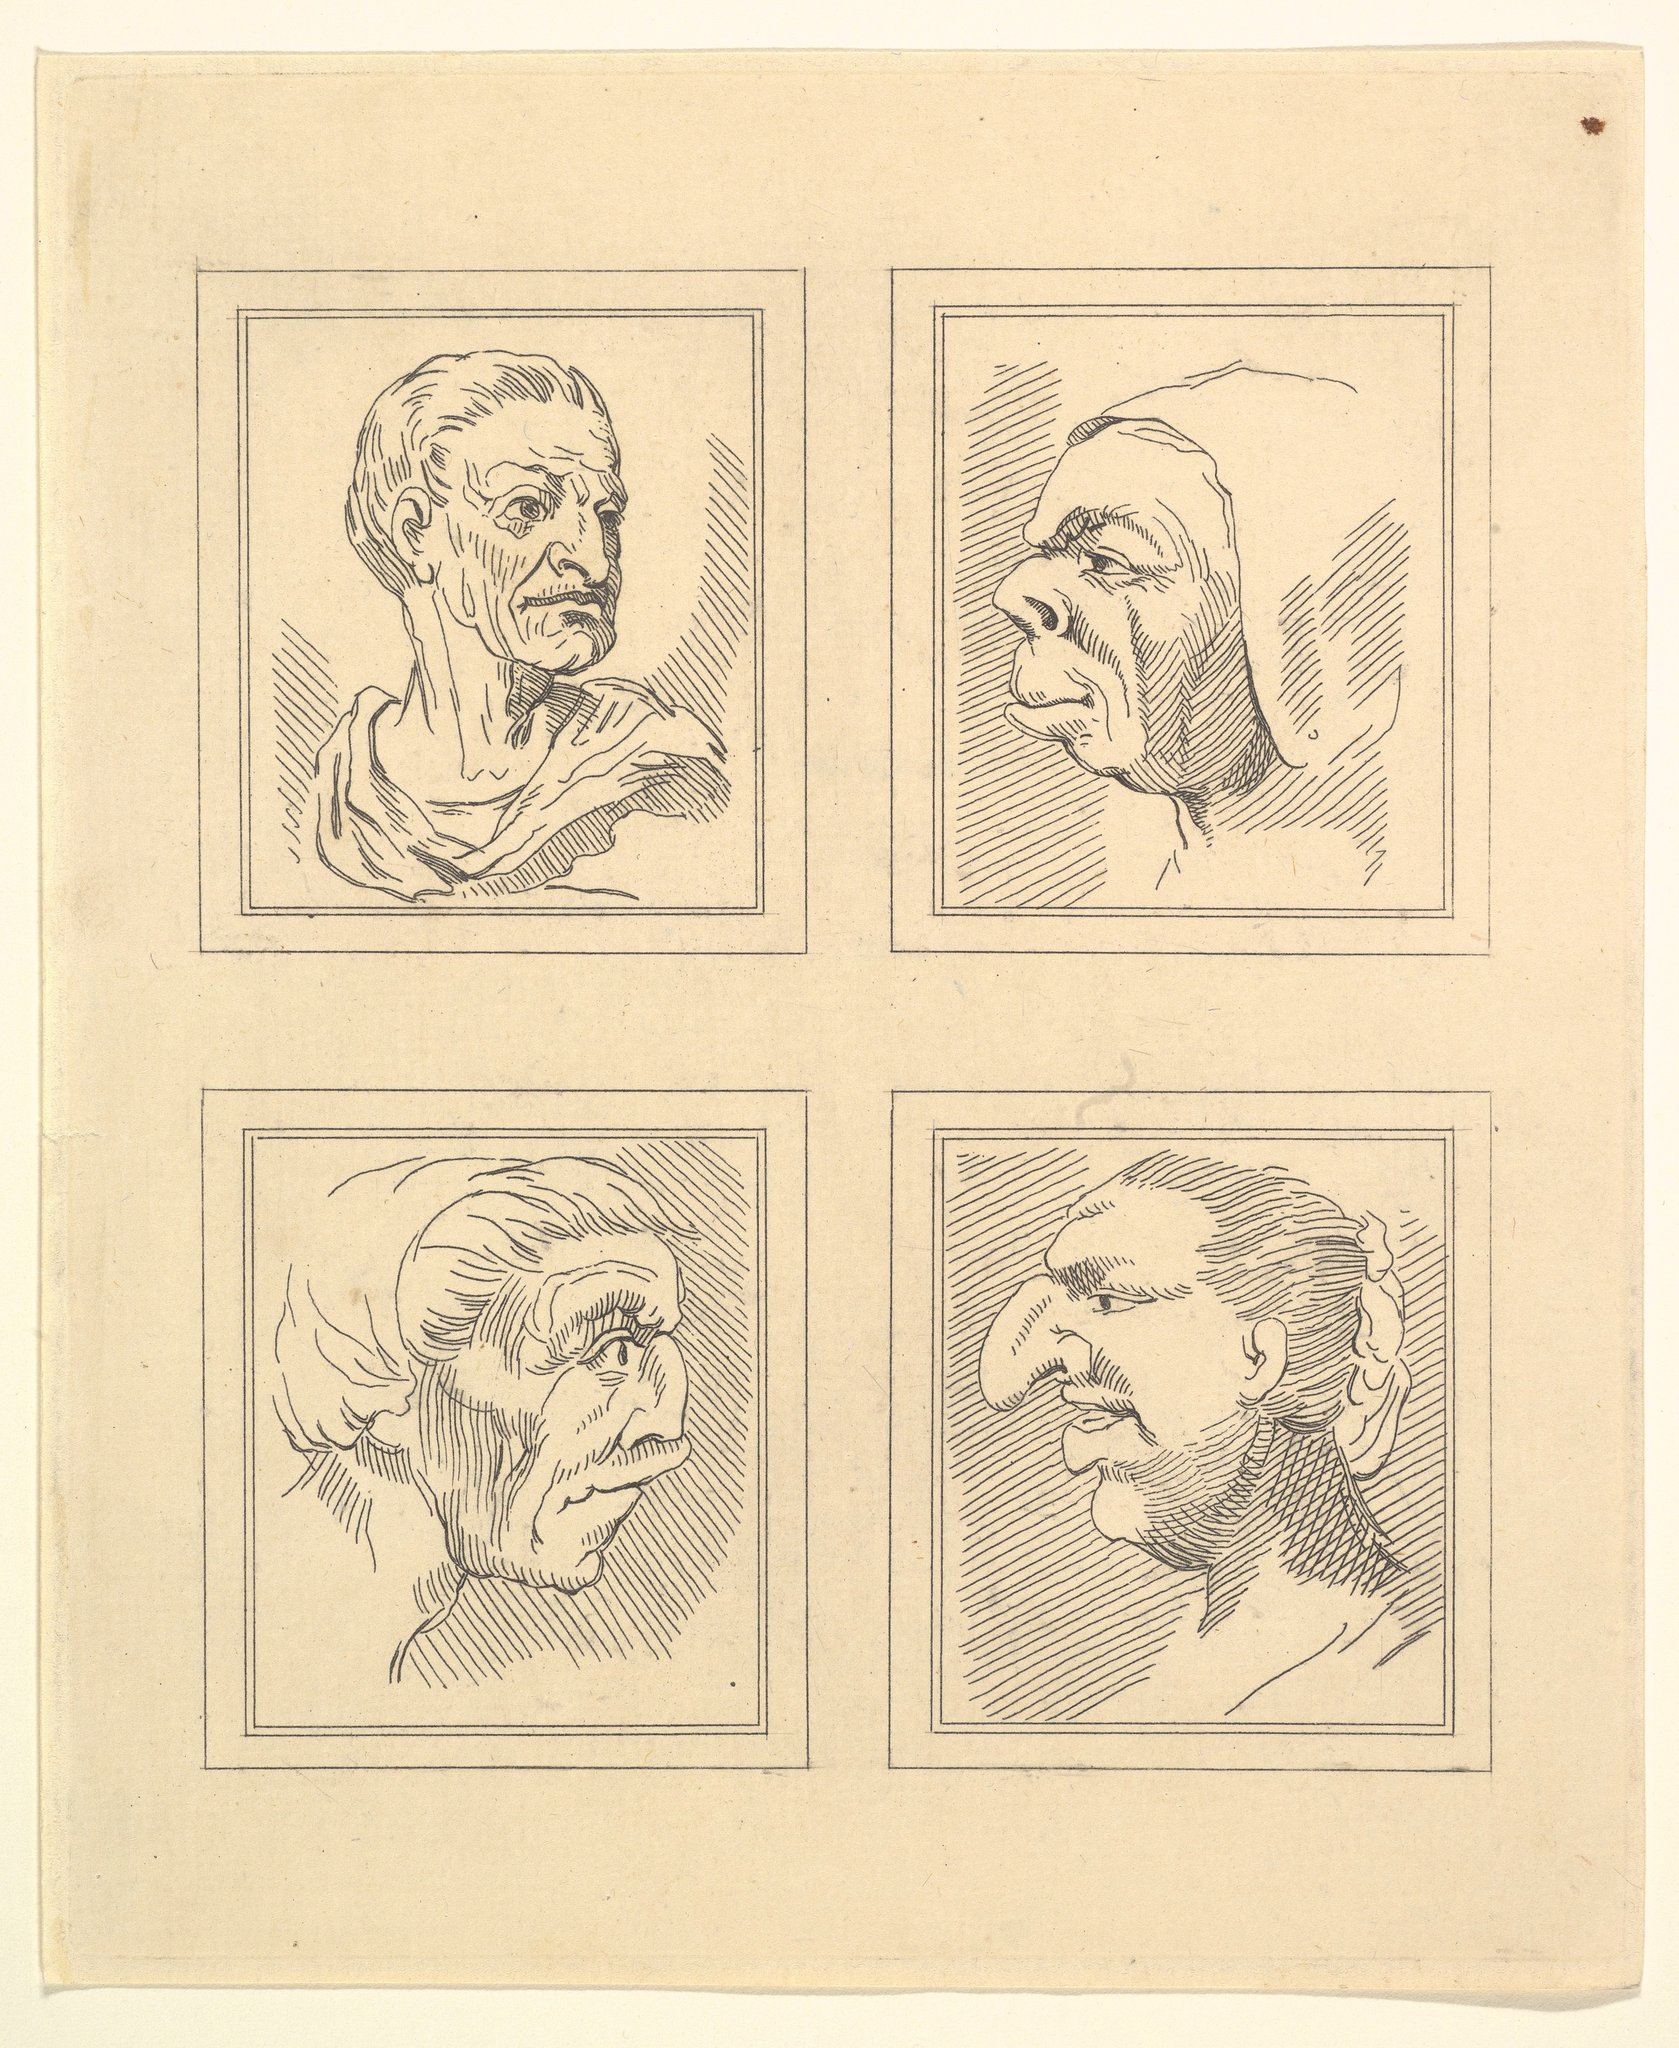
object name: print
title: Four Heads (from Characaturas by Leonardo da Vinci, from Drawings by Wincelslaus Hollar, out of the Portland Museum)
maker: wenceslaus hollar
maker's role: artist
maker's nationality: bohemian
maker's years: 1607-1677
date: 1786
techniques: etching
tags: heads